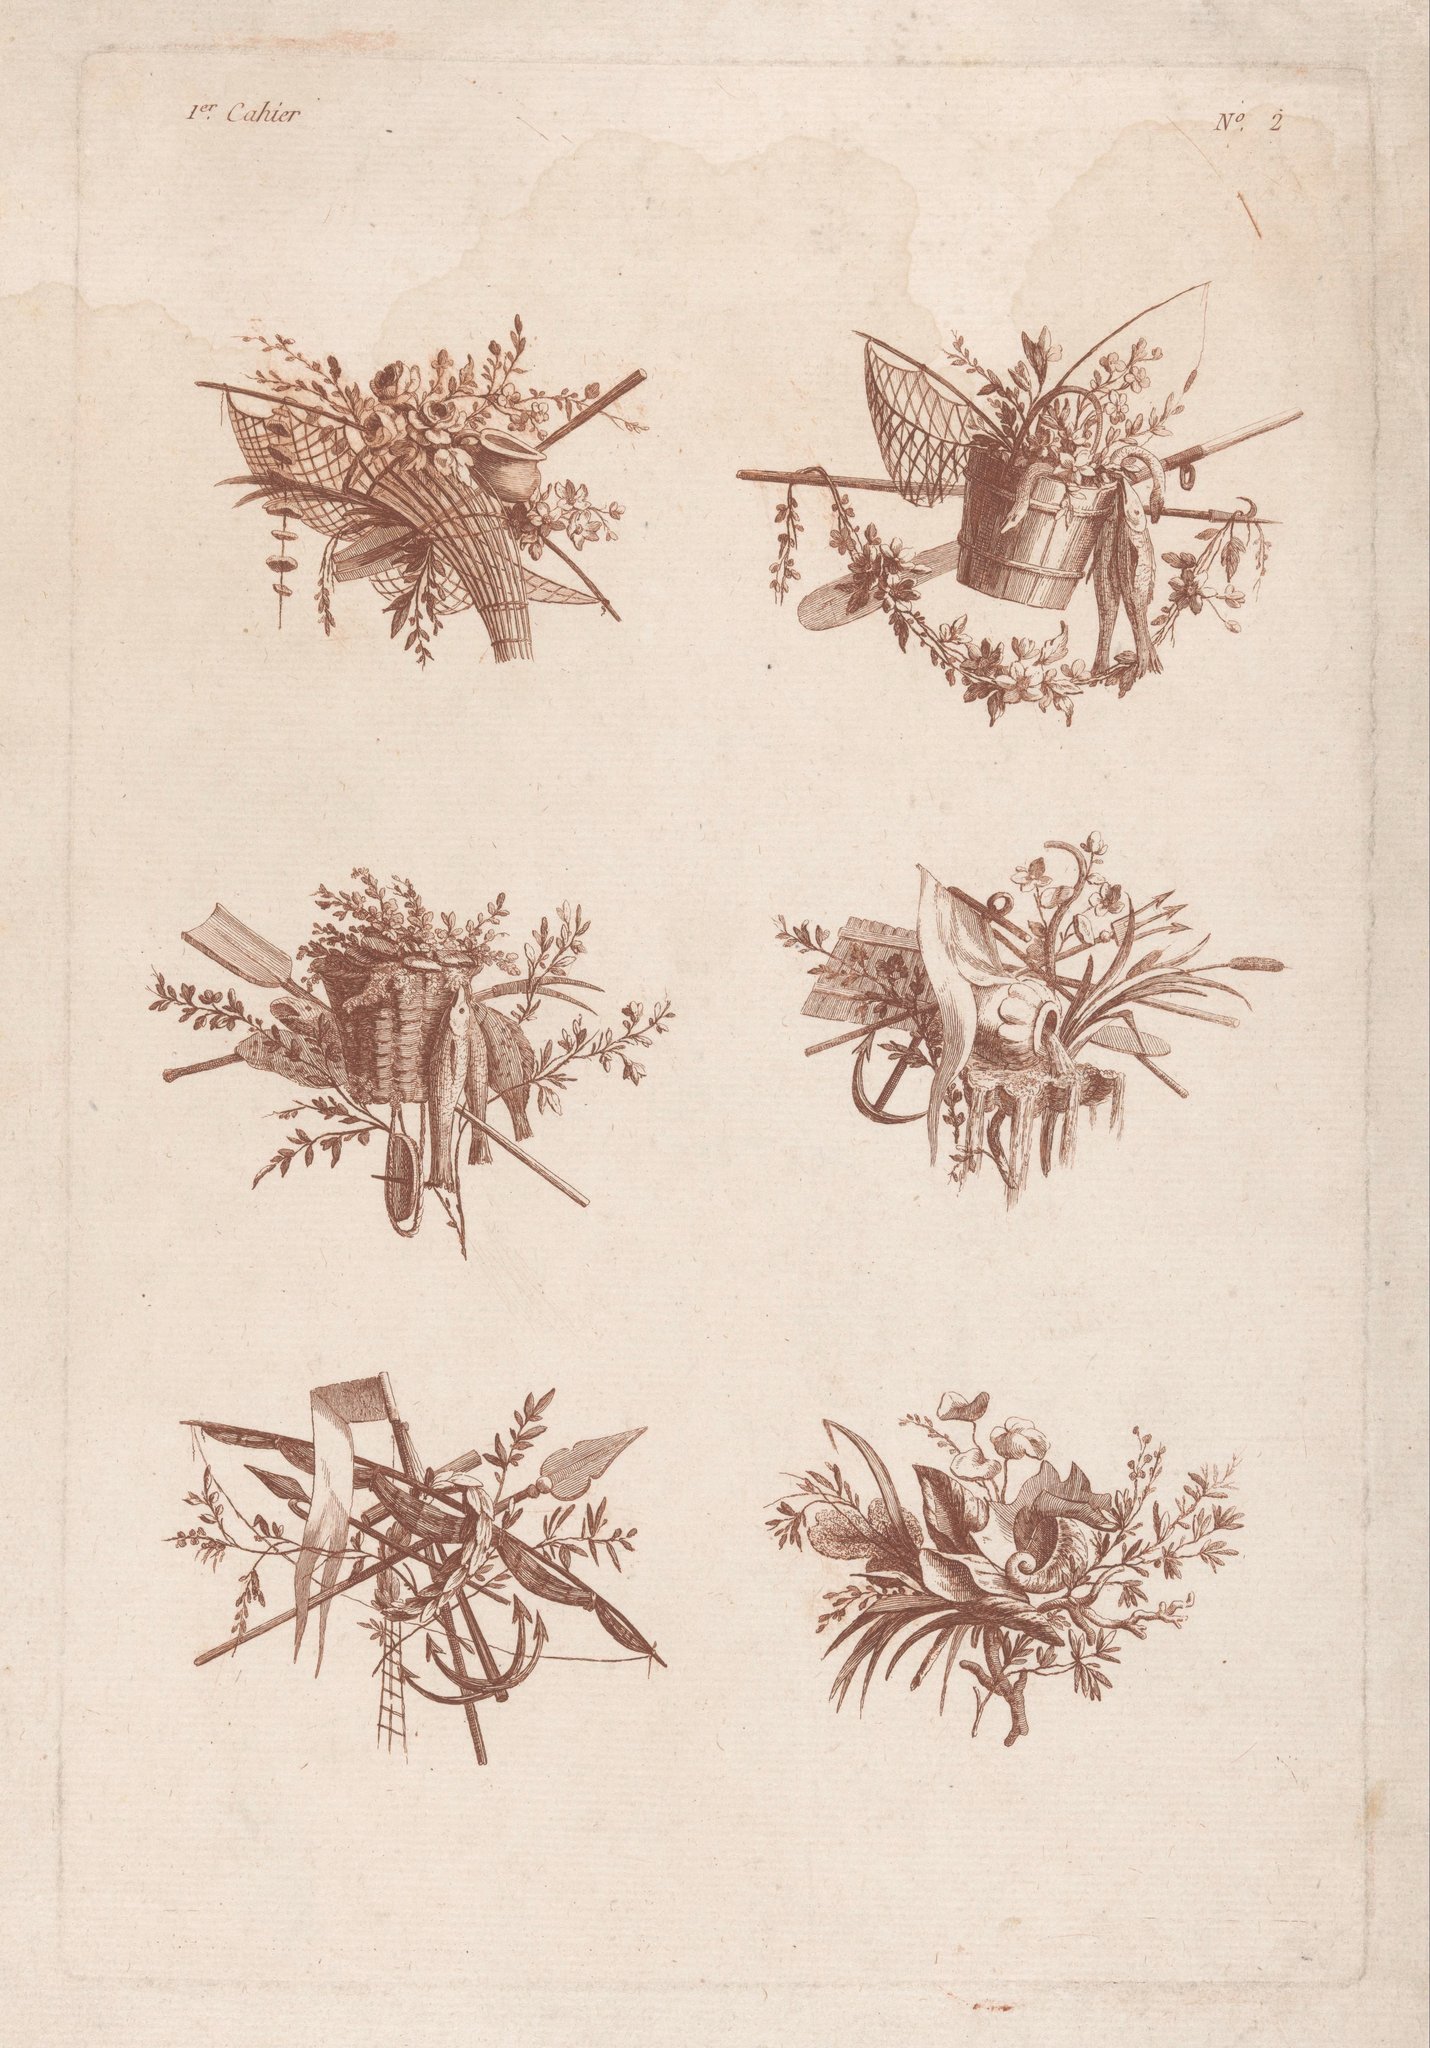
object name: ornament print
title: Ier Cahier de Trophées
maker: pierre gabriel berthault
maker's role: print maker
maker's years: 1737-1819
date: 1772-1779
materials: paper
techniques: etching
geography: paris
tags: trophy, i.e.: decorative arrangement of symbolic or typical objects ~ ornament, fishing (sports)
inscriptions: collector's mark: Lugt 2228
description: Zes trofeeën met vissersattributen zoals netten, emmers, vissen, een harpoen, een drietand, een anker, een mast en schelpen.